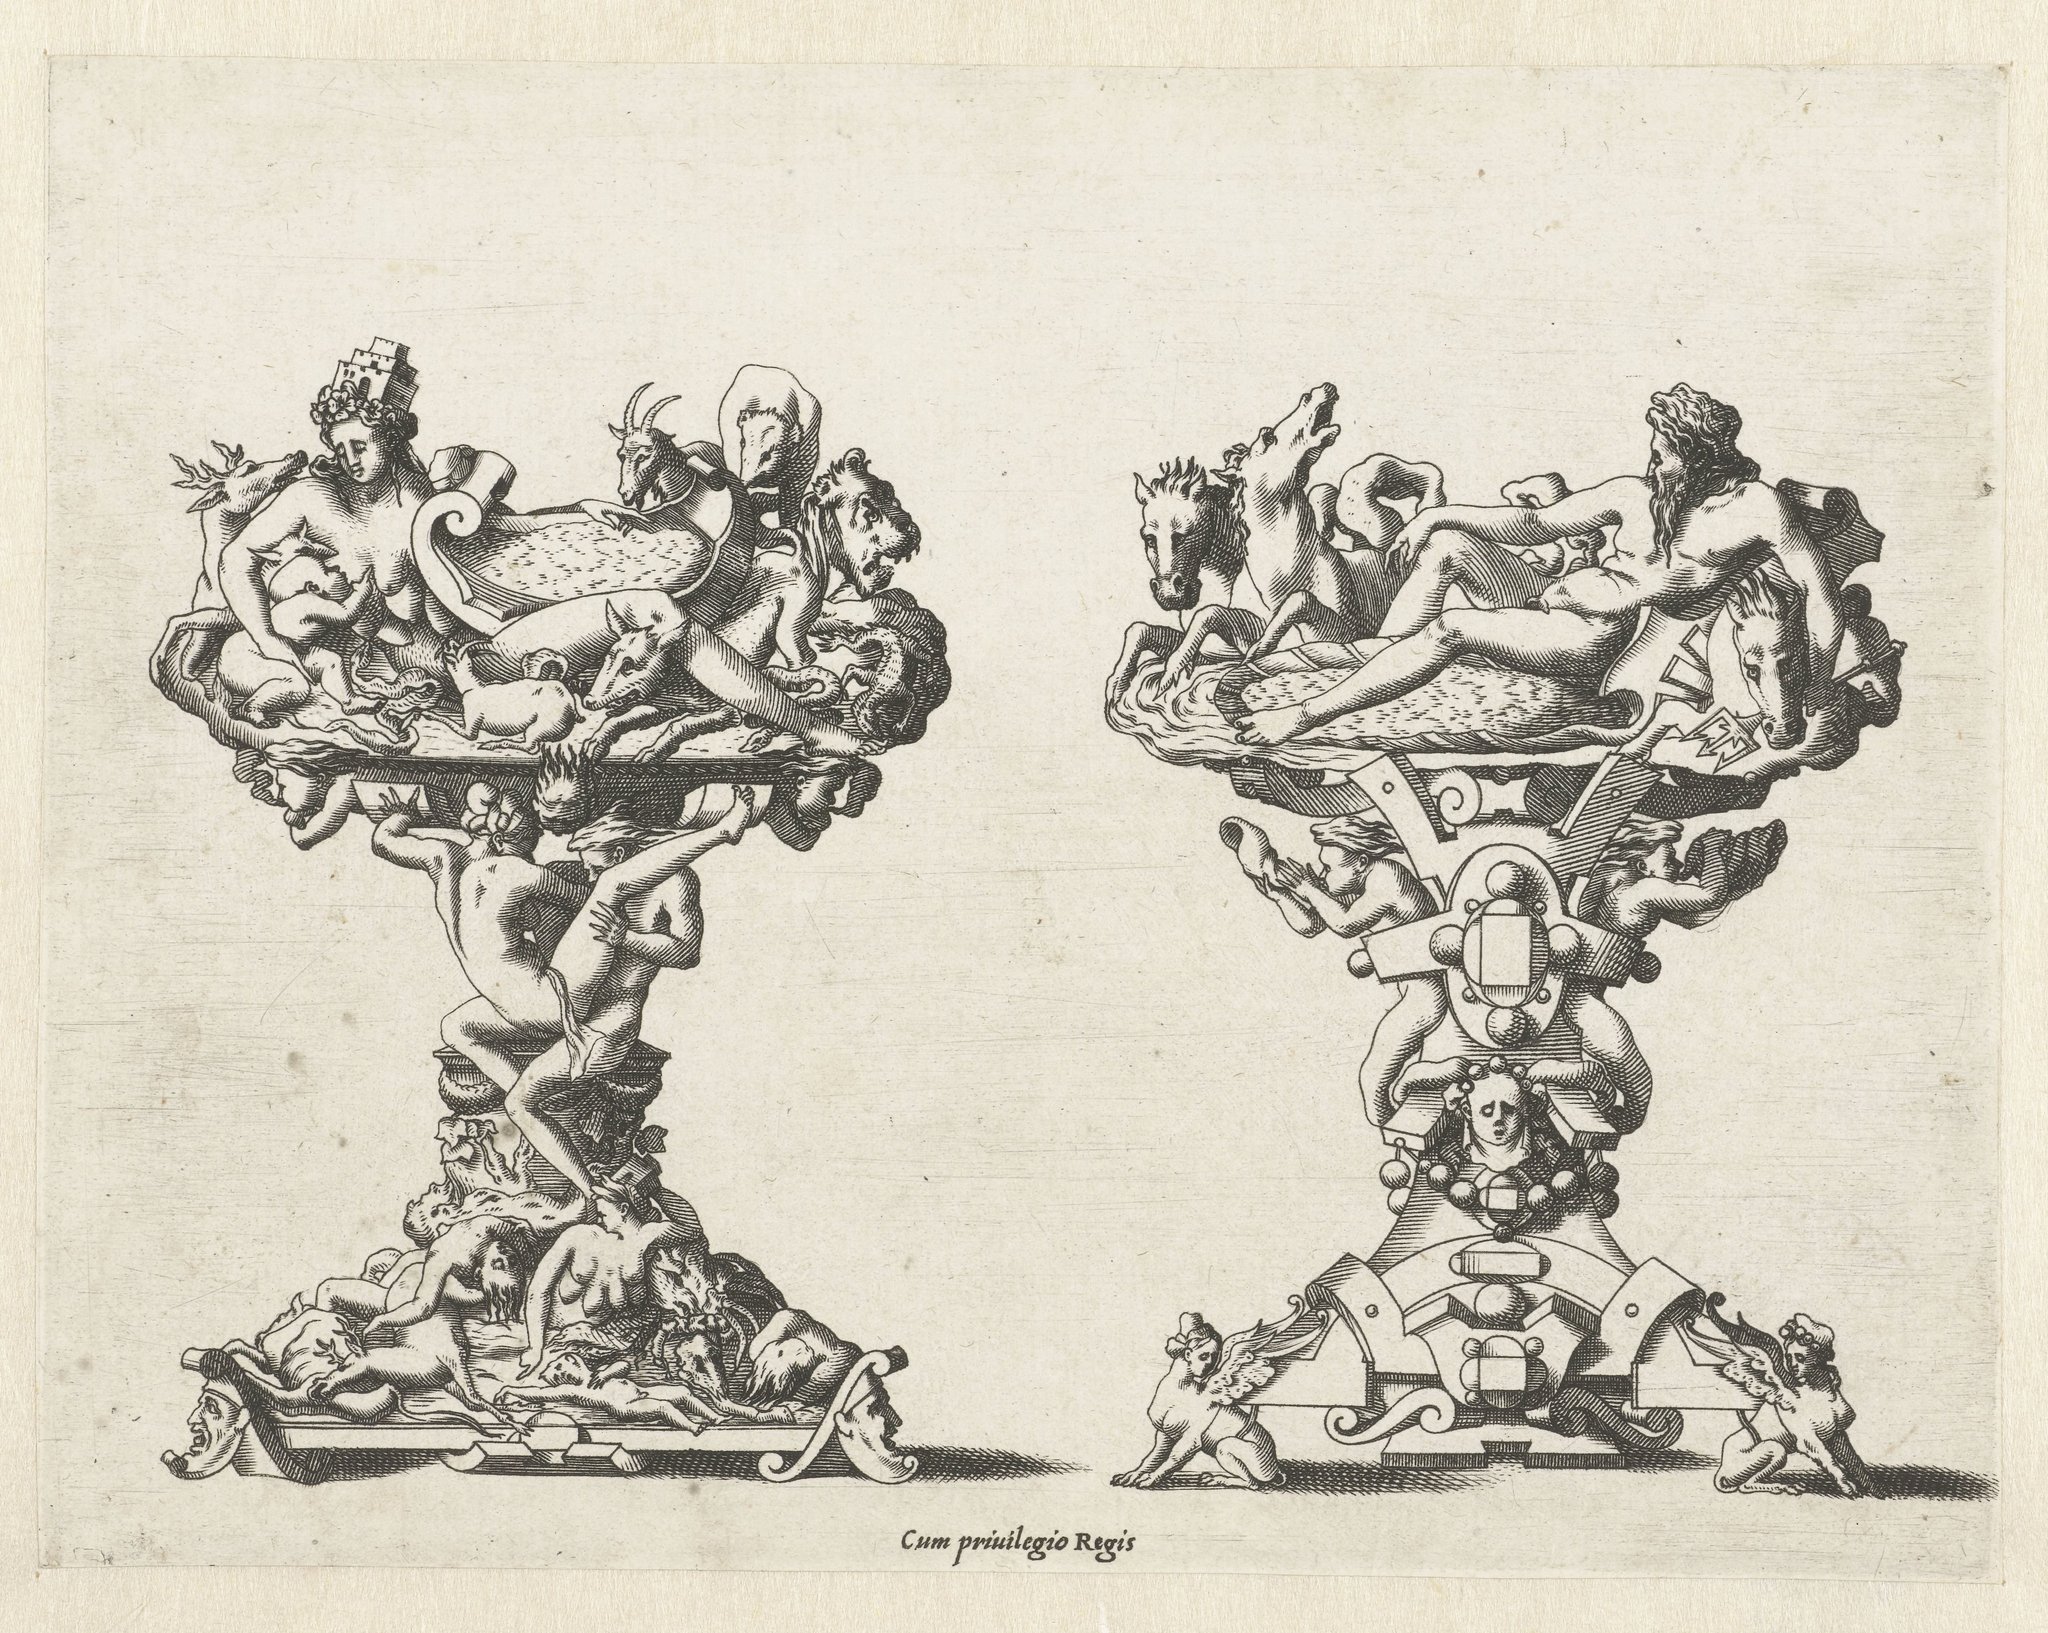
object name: ornament print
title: Twee zoutvaatjes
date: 1542-1580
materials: paper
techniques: engraving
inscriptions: collector's mark: Lugt 240, : ‘Cum priuilegio Regis.’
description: De stam van het linker vaatje bestaat uit een paar dat de liefde bedrijft, gezeten op een sokkel. Bovenaan ligt Cybele, omringd door dieren met een baby aan haar borsten. Zij houdt het eigenlijke zoutvat op haar schoot. De stam van het rechter zoutvaatje is gedecoreerd met rolwerk waarin twee tritons gevangen zijn die op een schelp blazen. Bovenaan zit Neptunus op zijn wagen die de vorm van een schelp heeft. Hierin bevindt zich het echte zoutvat.